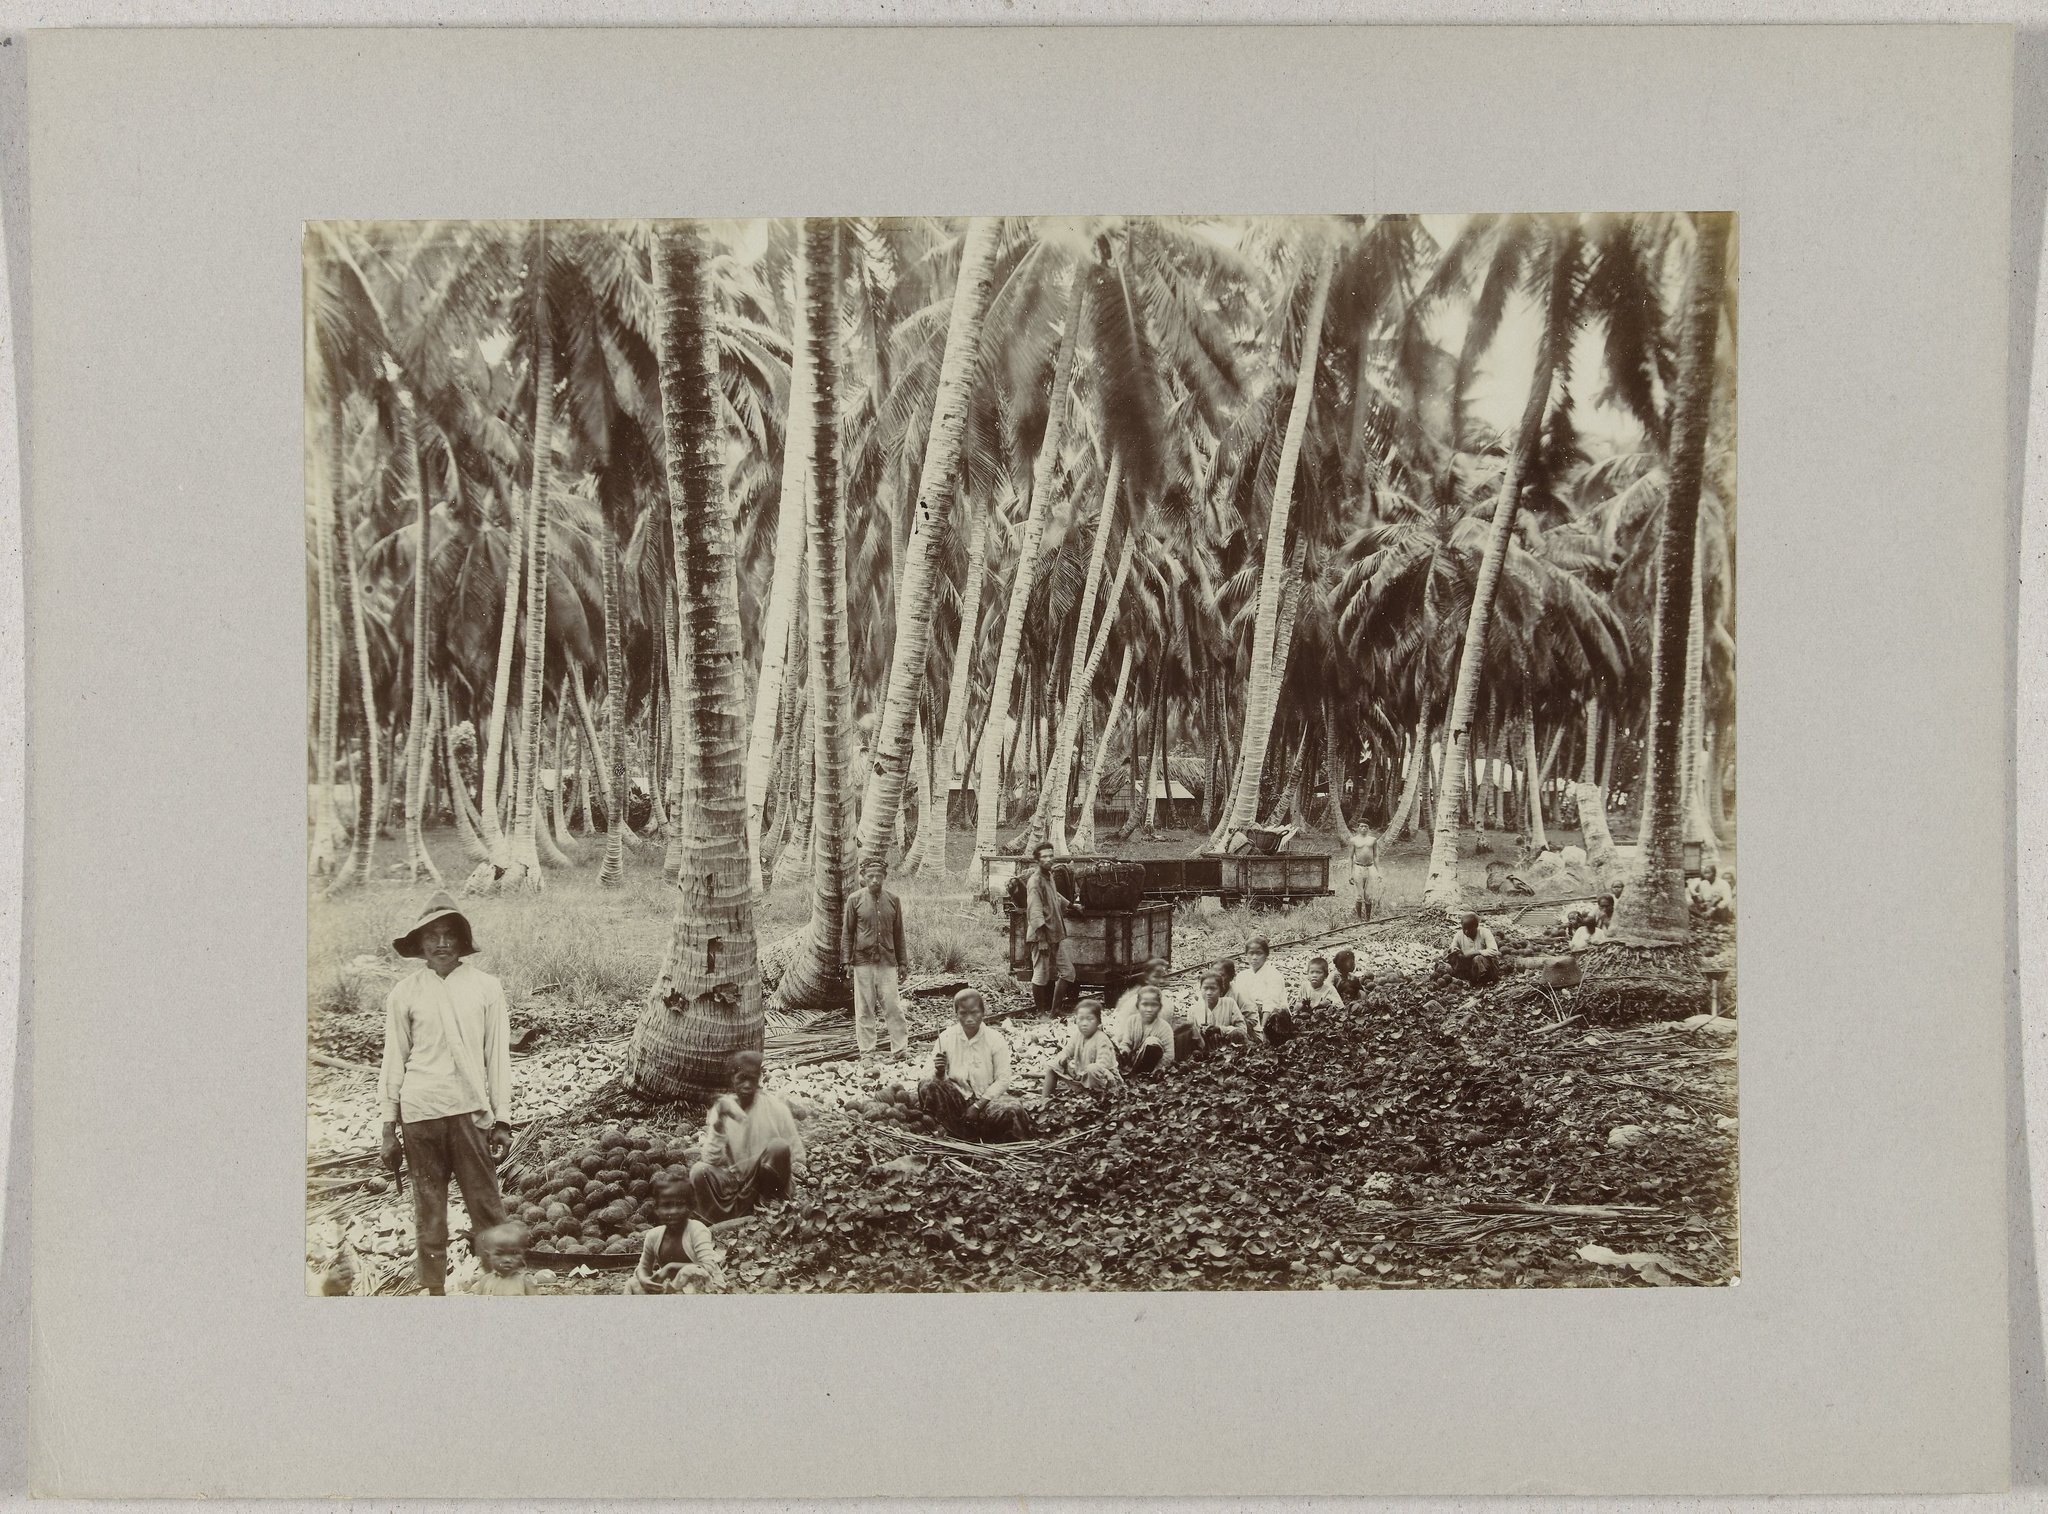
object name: photograph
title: Plantage met kokospalmen in Nederlands-Indië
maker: Anonymous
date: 1895-1915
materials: cardboard, paper, photographic support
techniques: gelatin silver print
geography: dutch east indies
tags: indonesia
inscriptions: number: ‘24’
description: Plantage met kokospalmen, Nederlands-Indië. Vrouwen en kinderen zijn bezig met het openen van de kokosvruchten om de kokosnoten er uit te halen. Mannen vervoeren de kokosnoten met een kar op een rails.